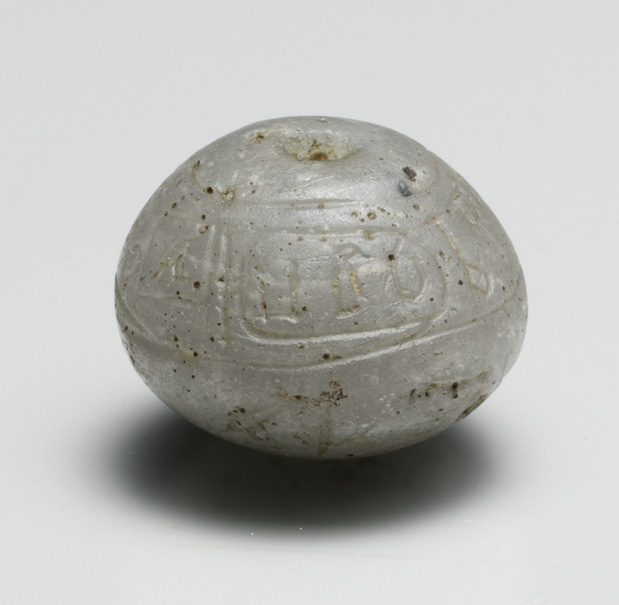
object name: bead, ball, hatshepsut, senenmut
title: Ball Bead with the Names of Hatshepsut and the Overseer of Work Senenmut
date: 1479-1458 BCE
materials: glass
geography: upper egypt, thebes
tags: hieroglyphs